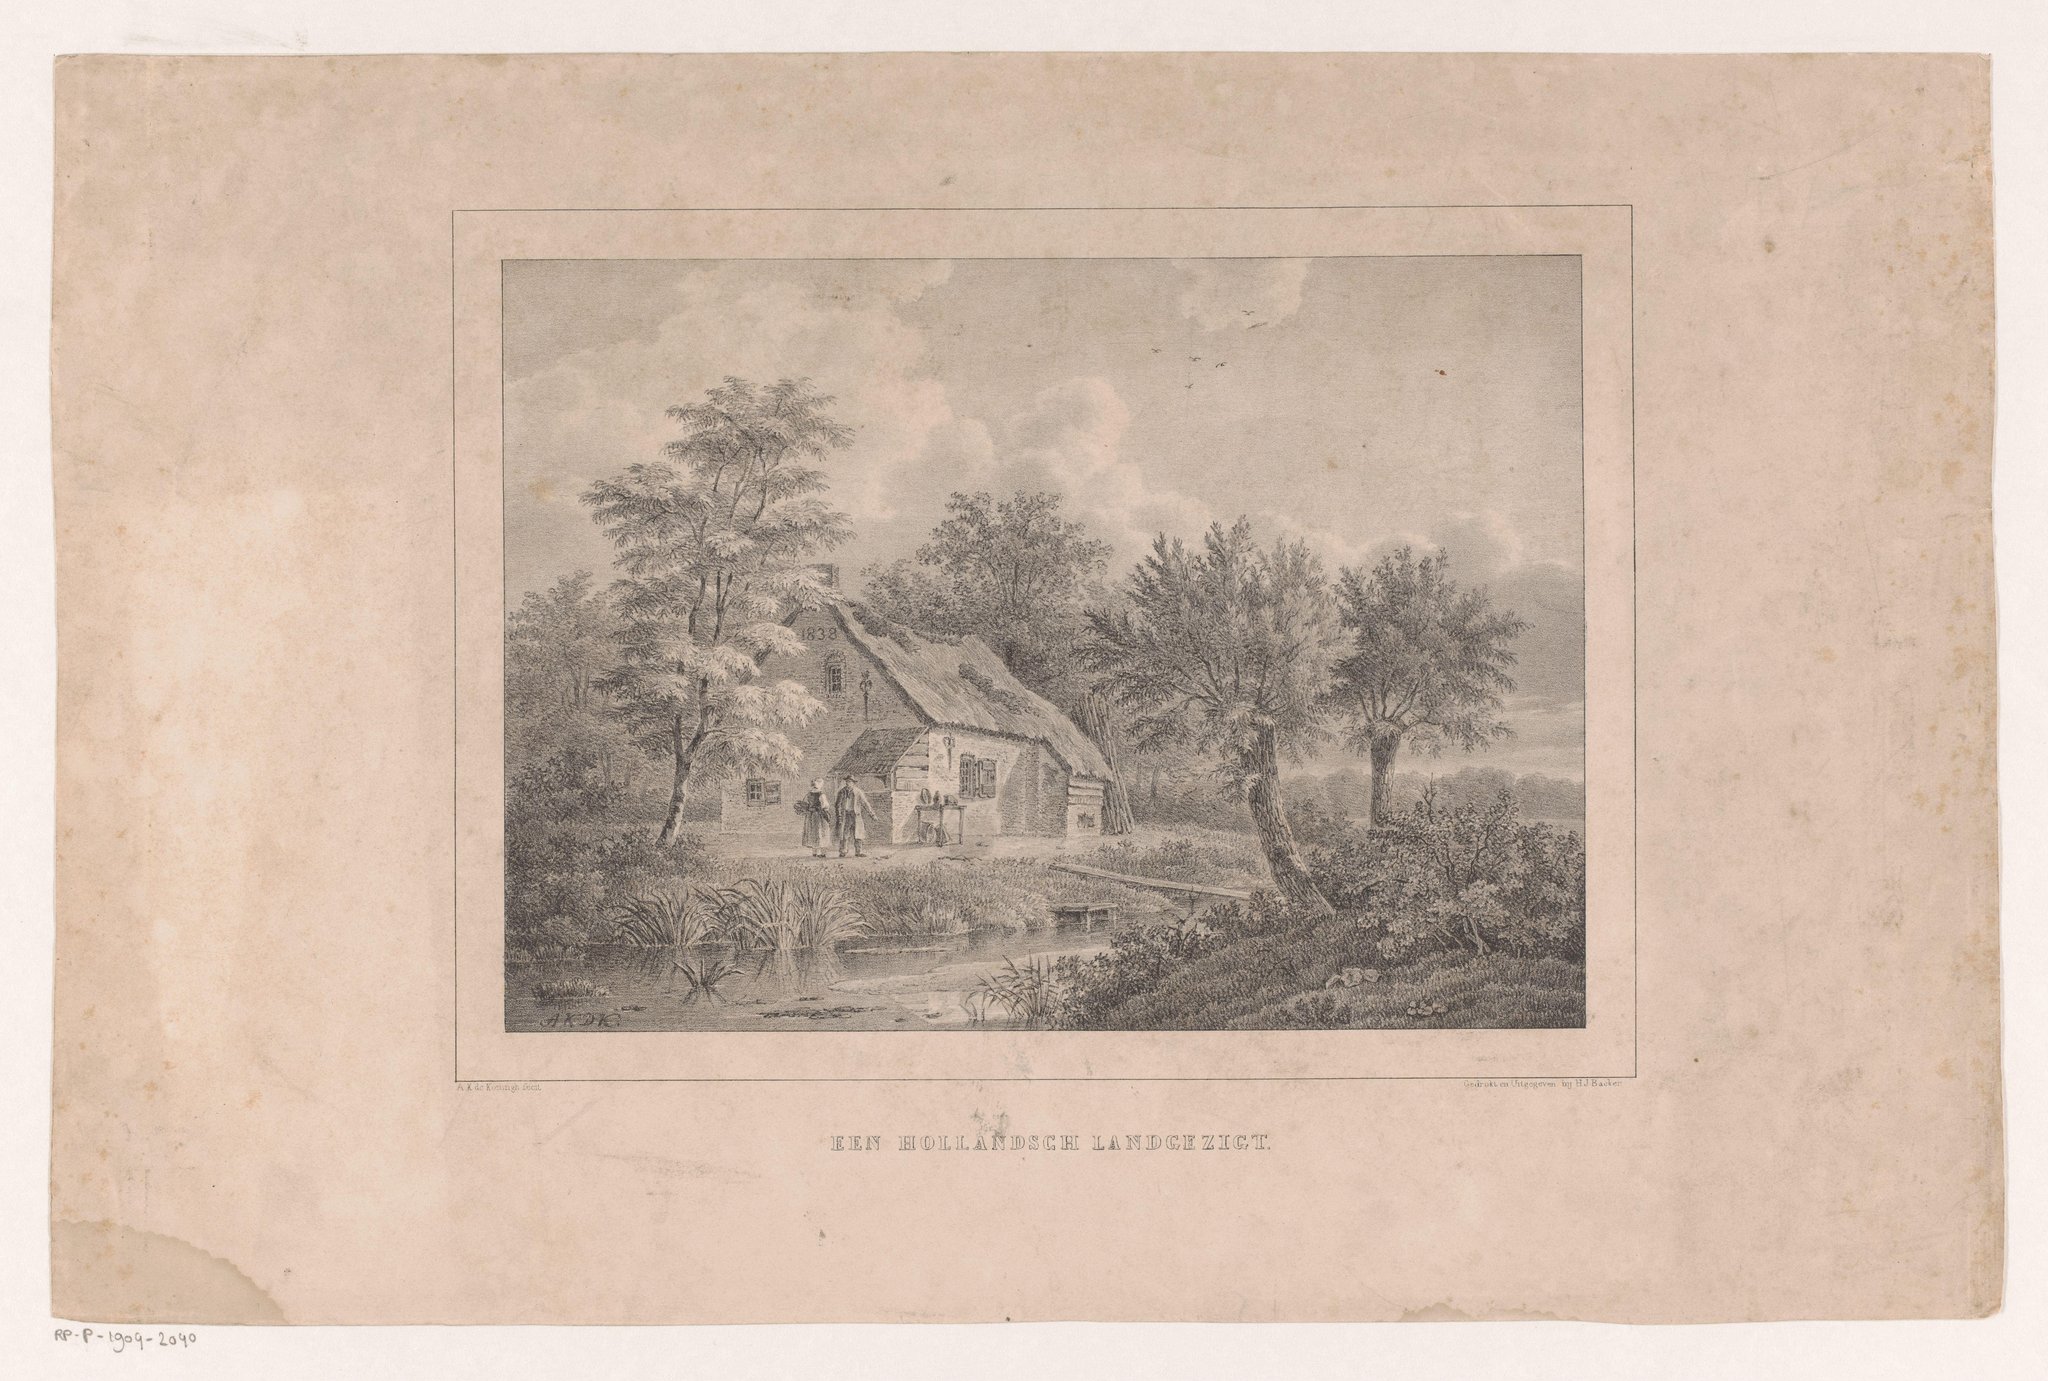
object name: print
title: Landschap met boerderij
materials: paper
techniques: lithograph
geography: dordrecht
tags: trees: willow, small canal, ditch, farm or solitary house in landscape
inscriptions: collector's mark: Lugt 2228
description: Voor de boerderij staan een man en een vrouw. Op de gevel het jaartal 1838. Rechts aan het water twee knotwilgen.